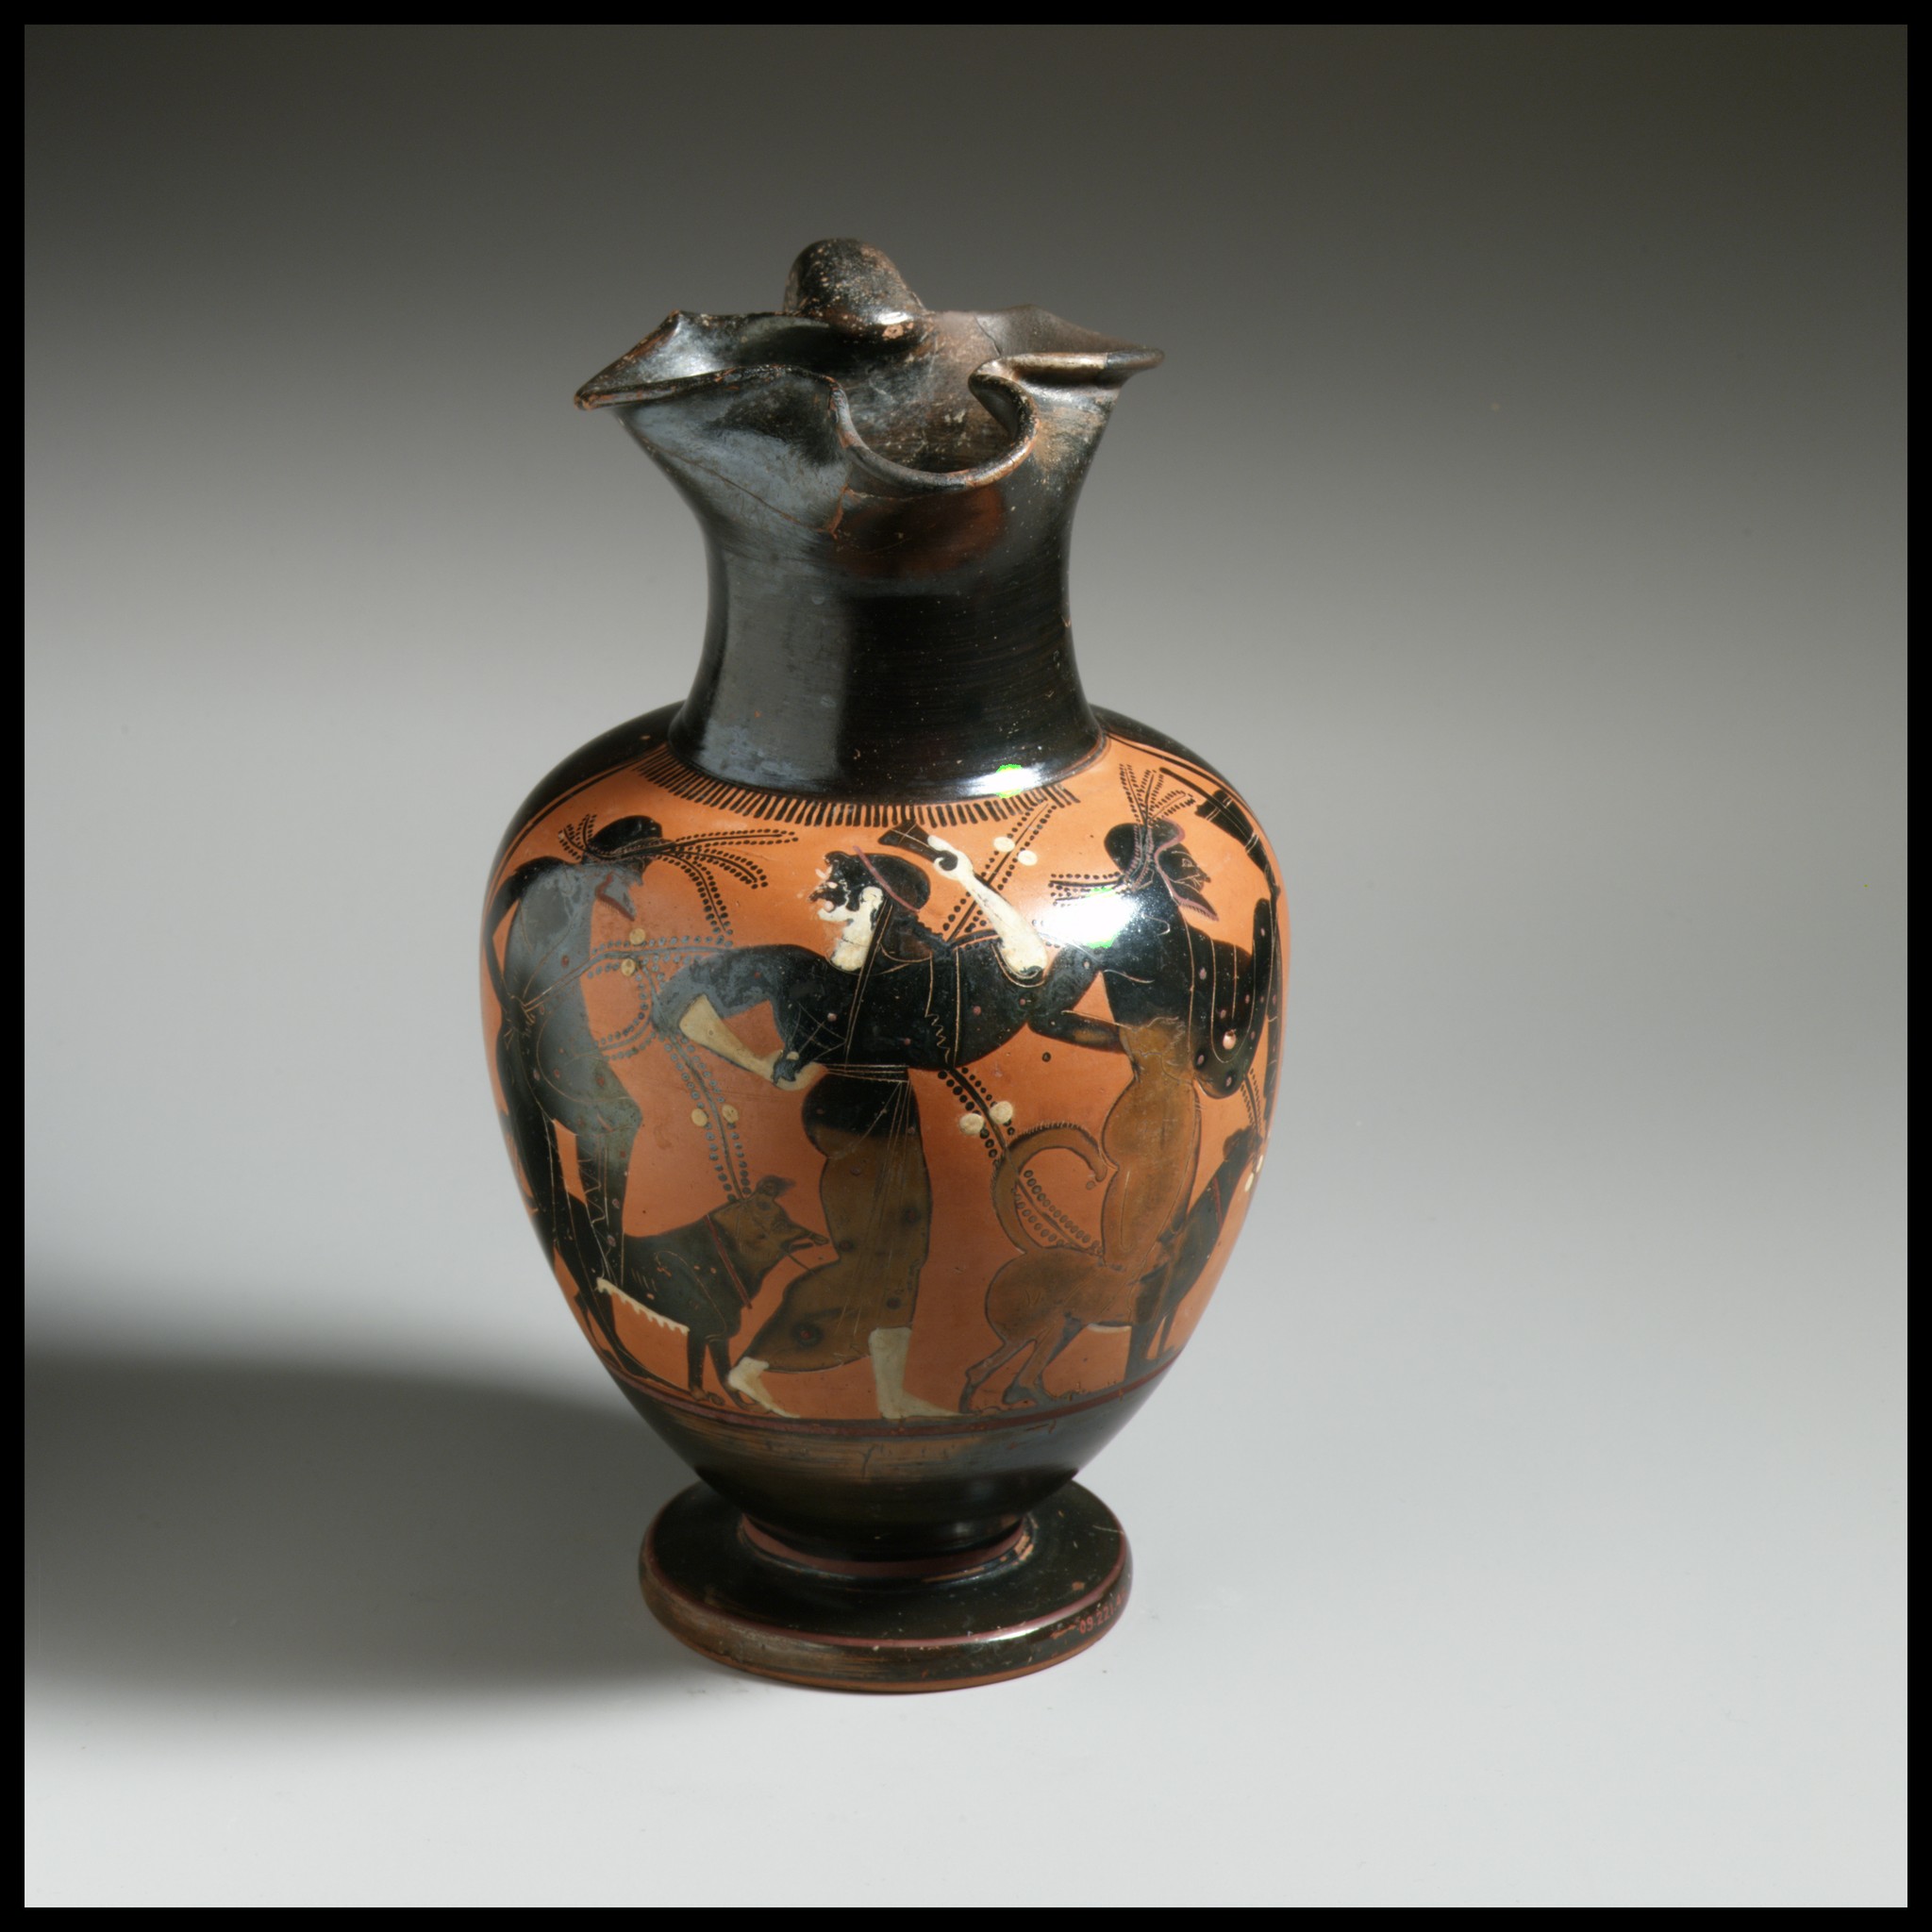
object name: oinochoe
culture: greek, attic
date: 525-501 BCE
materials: terracotta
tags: human figures,animals